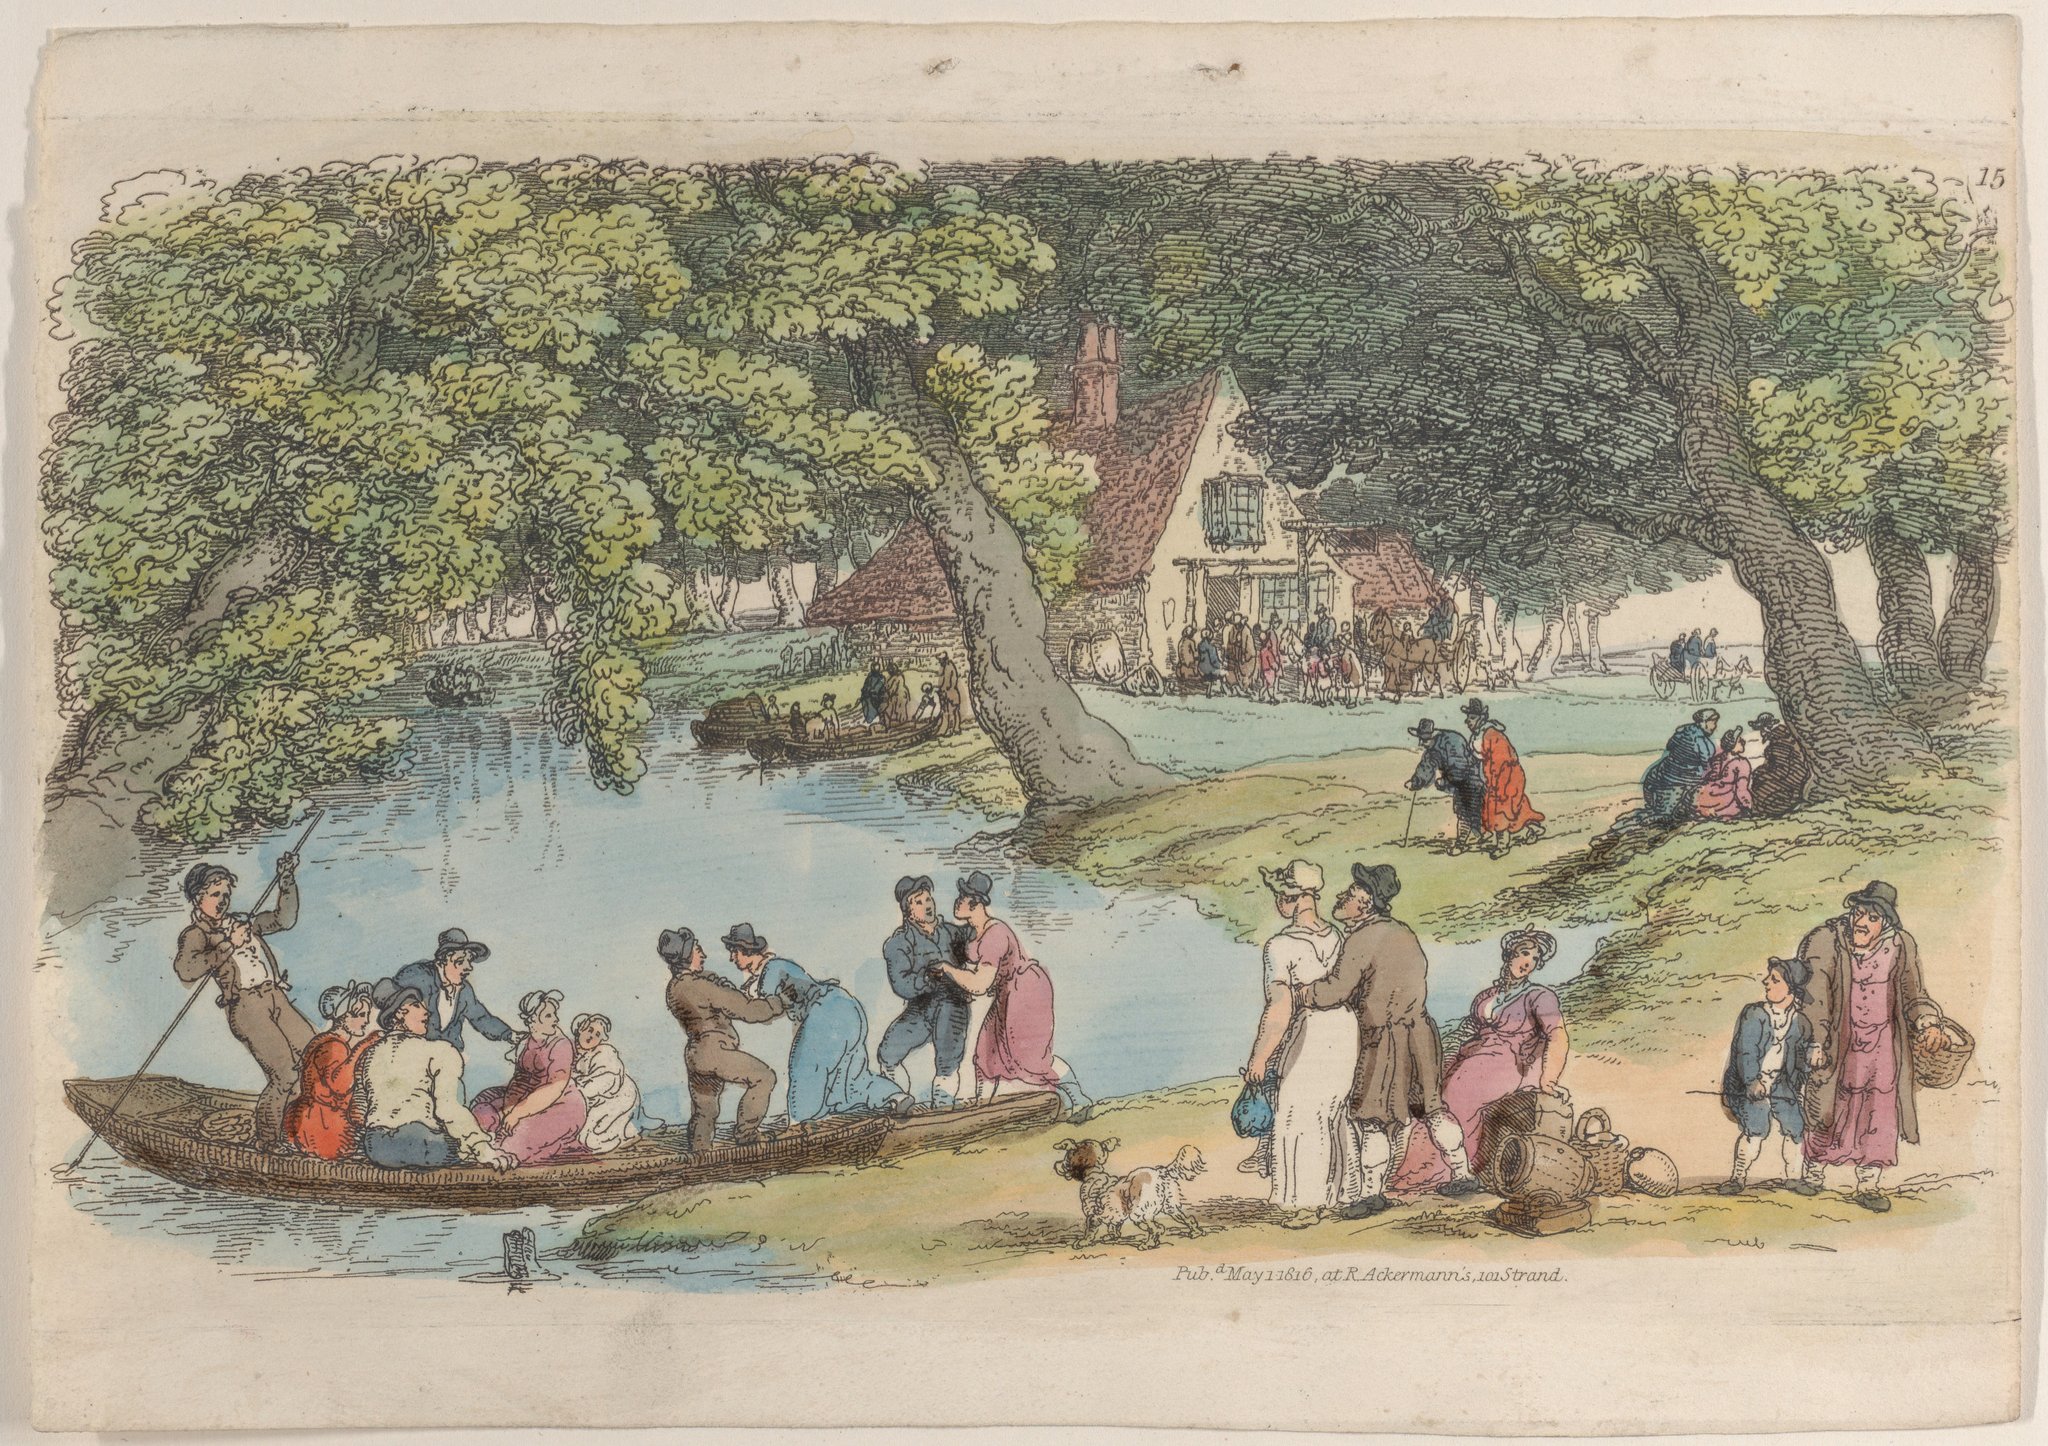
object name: print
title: Plate 15, from "World in Miniature"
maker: thomas rowlandson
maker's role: artist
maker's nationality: british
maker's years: 1757-1827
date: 1816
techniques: etching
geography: london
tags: men,women,dogs,rivers,boats